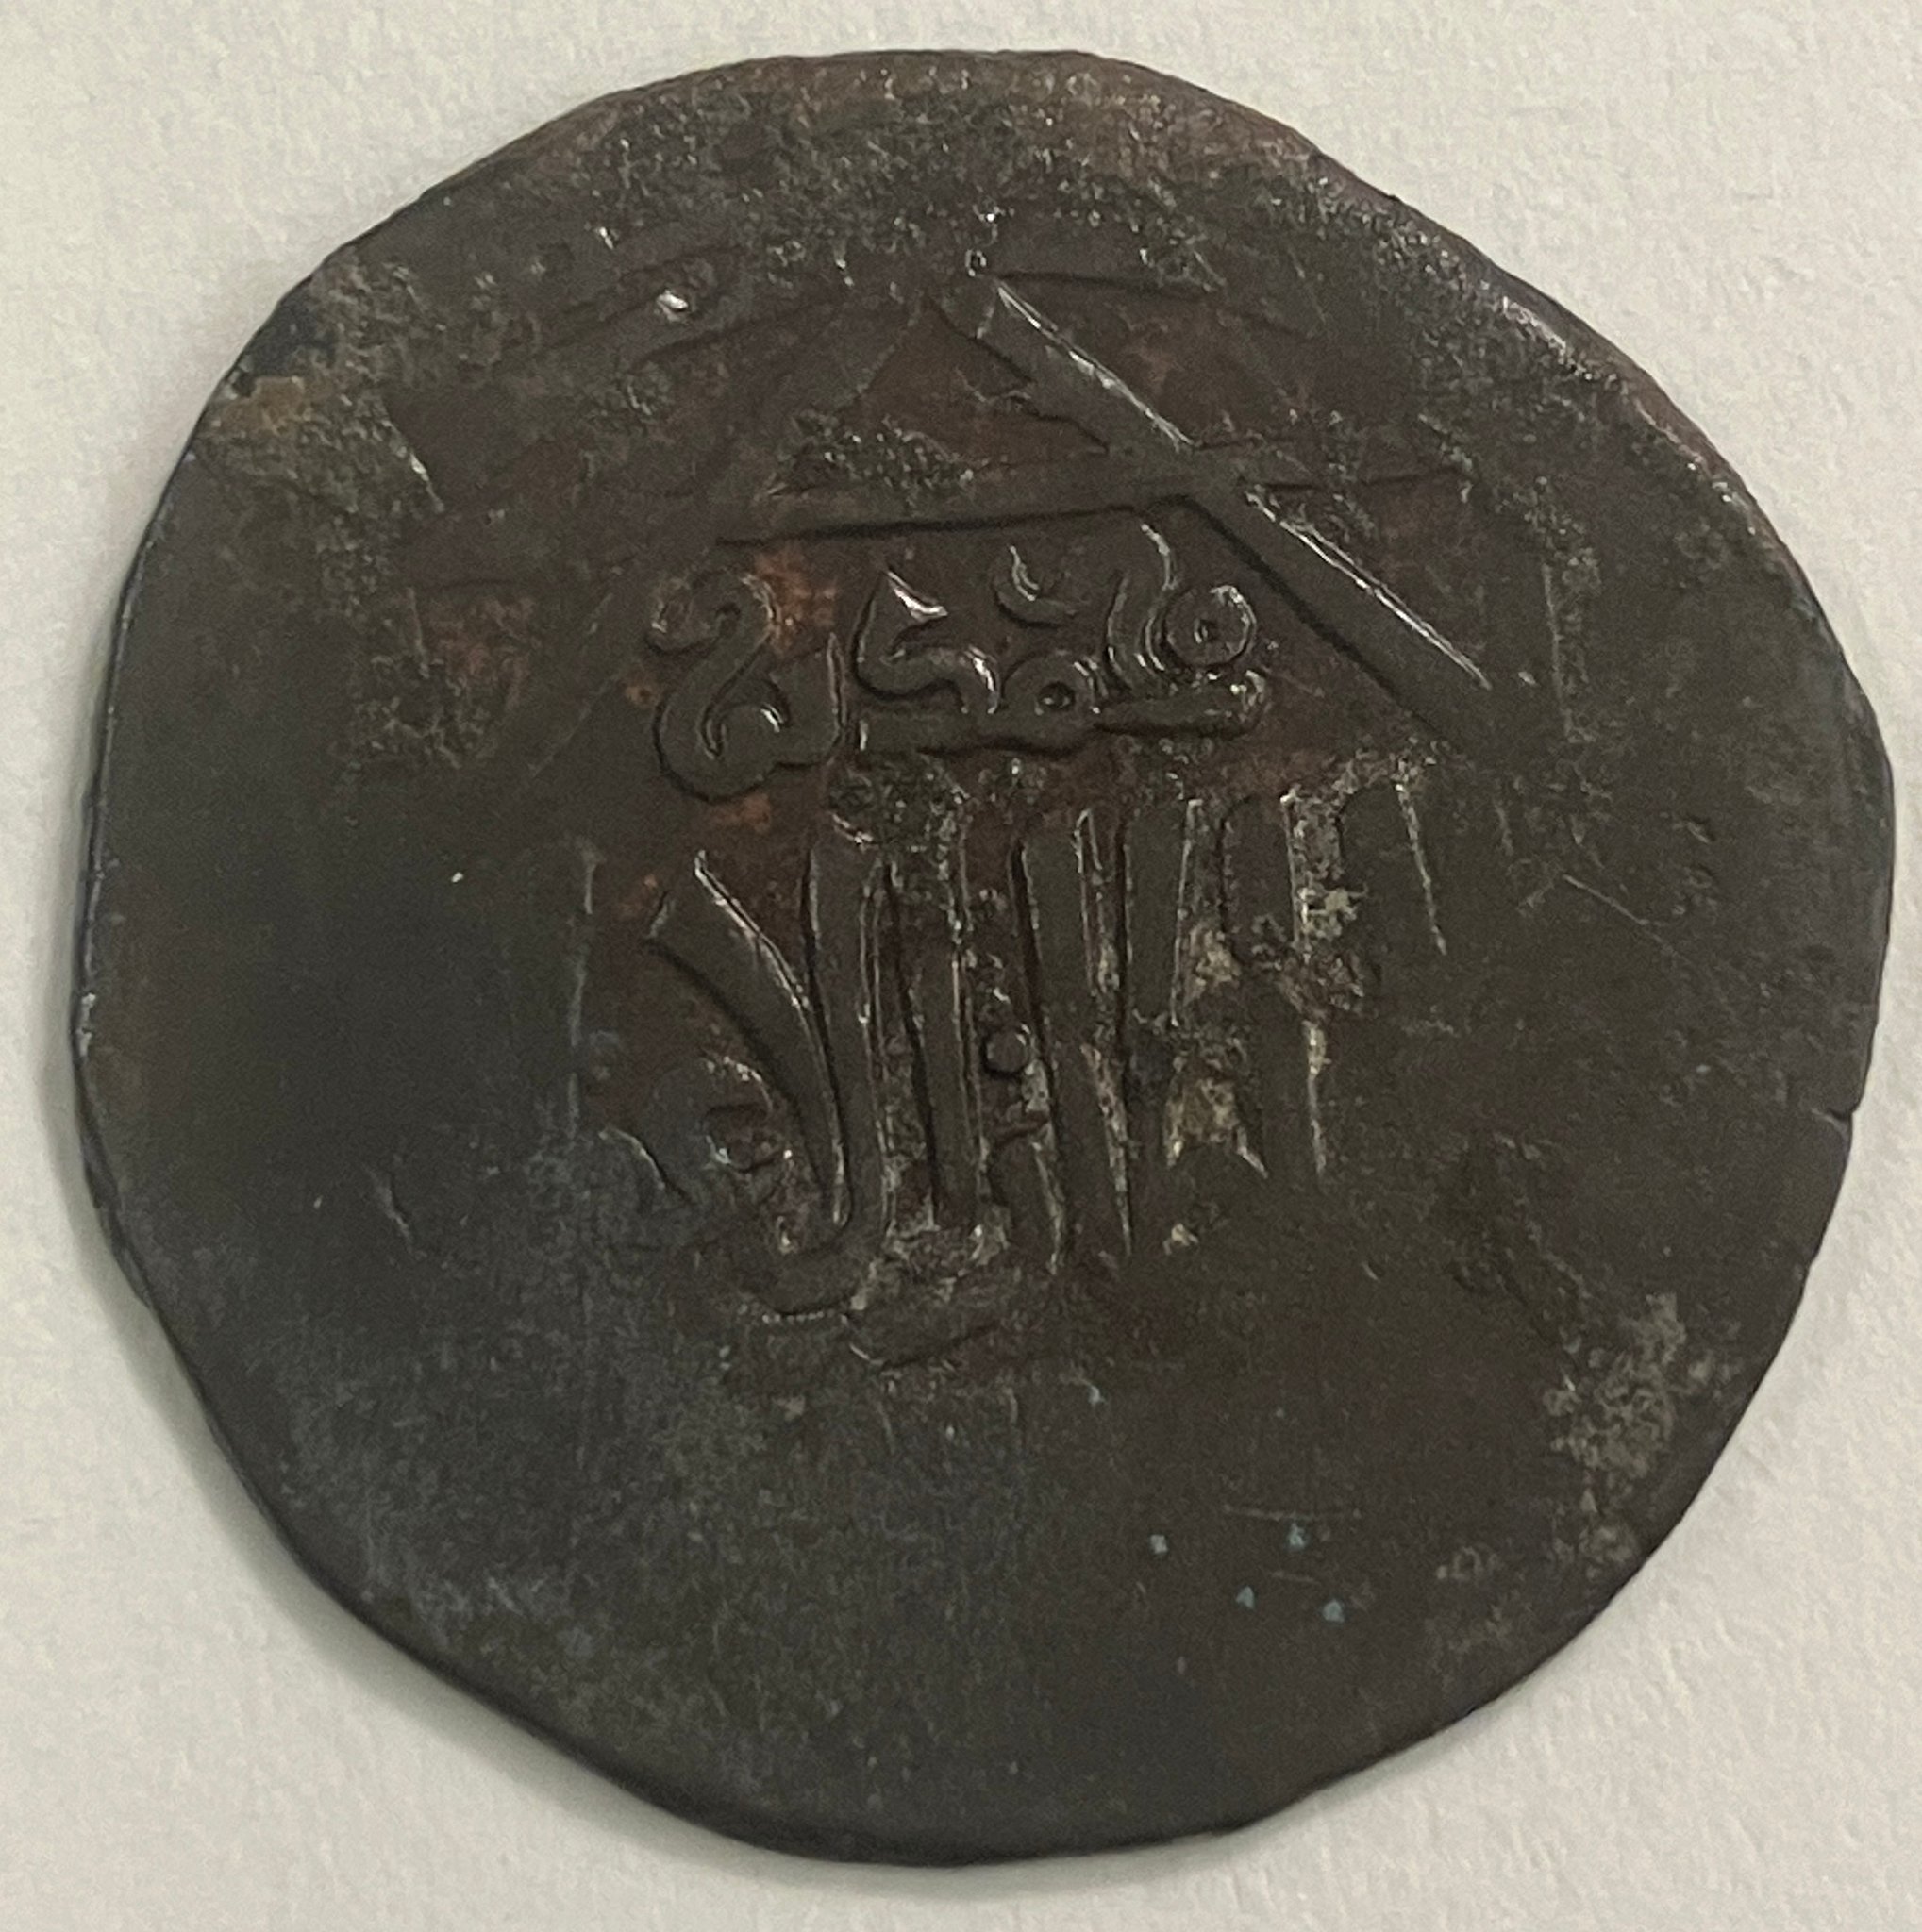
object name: coin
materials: copper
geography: iran